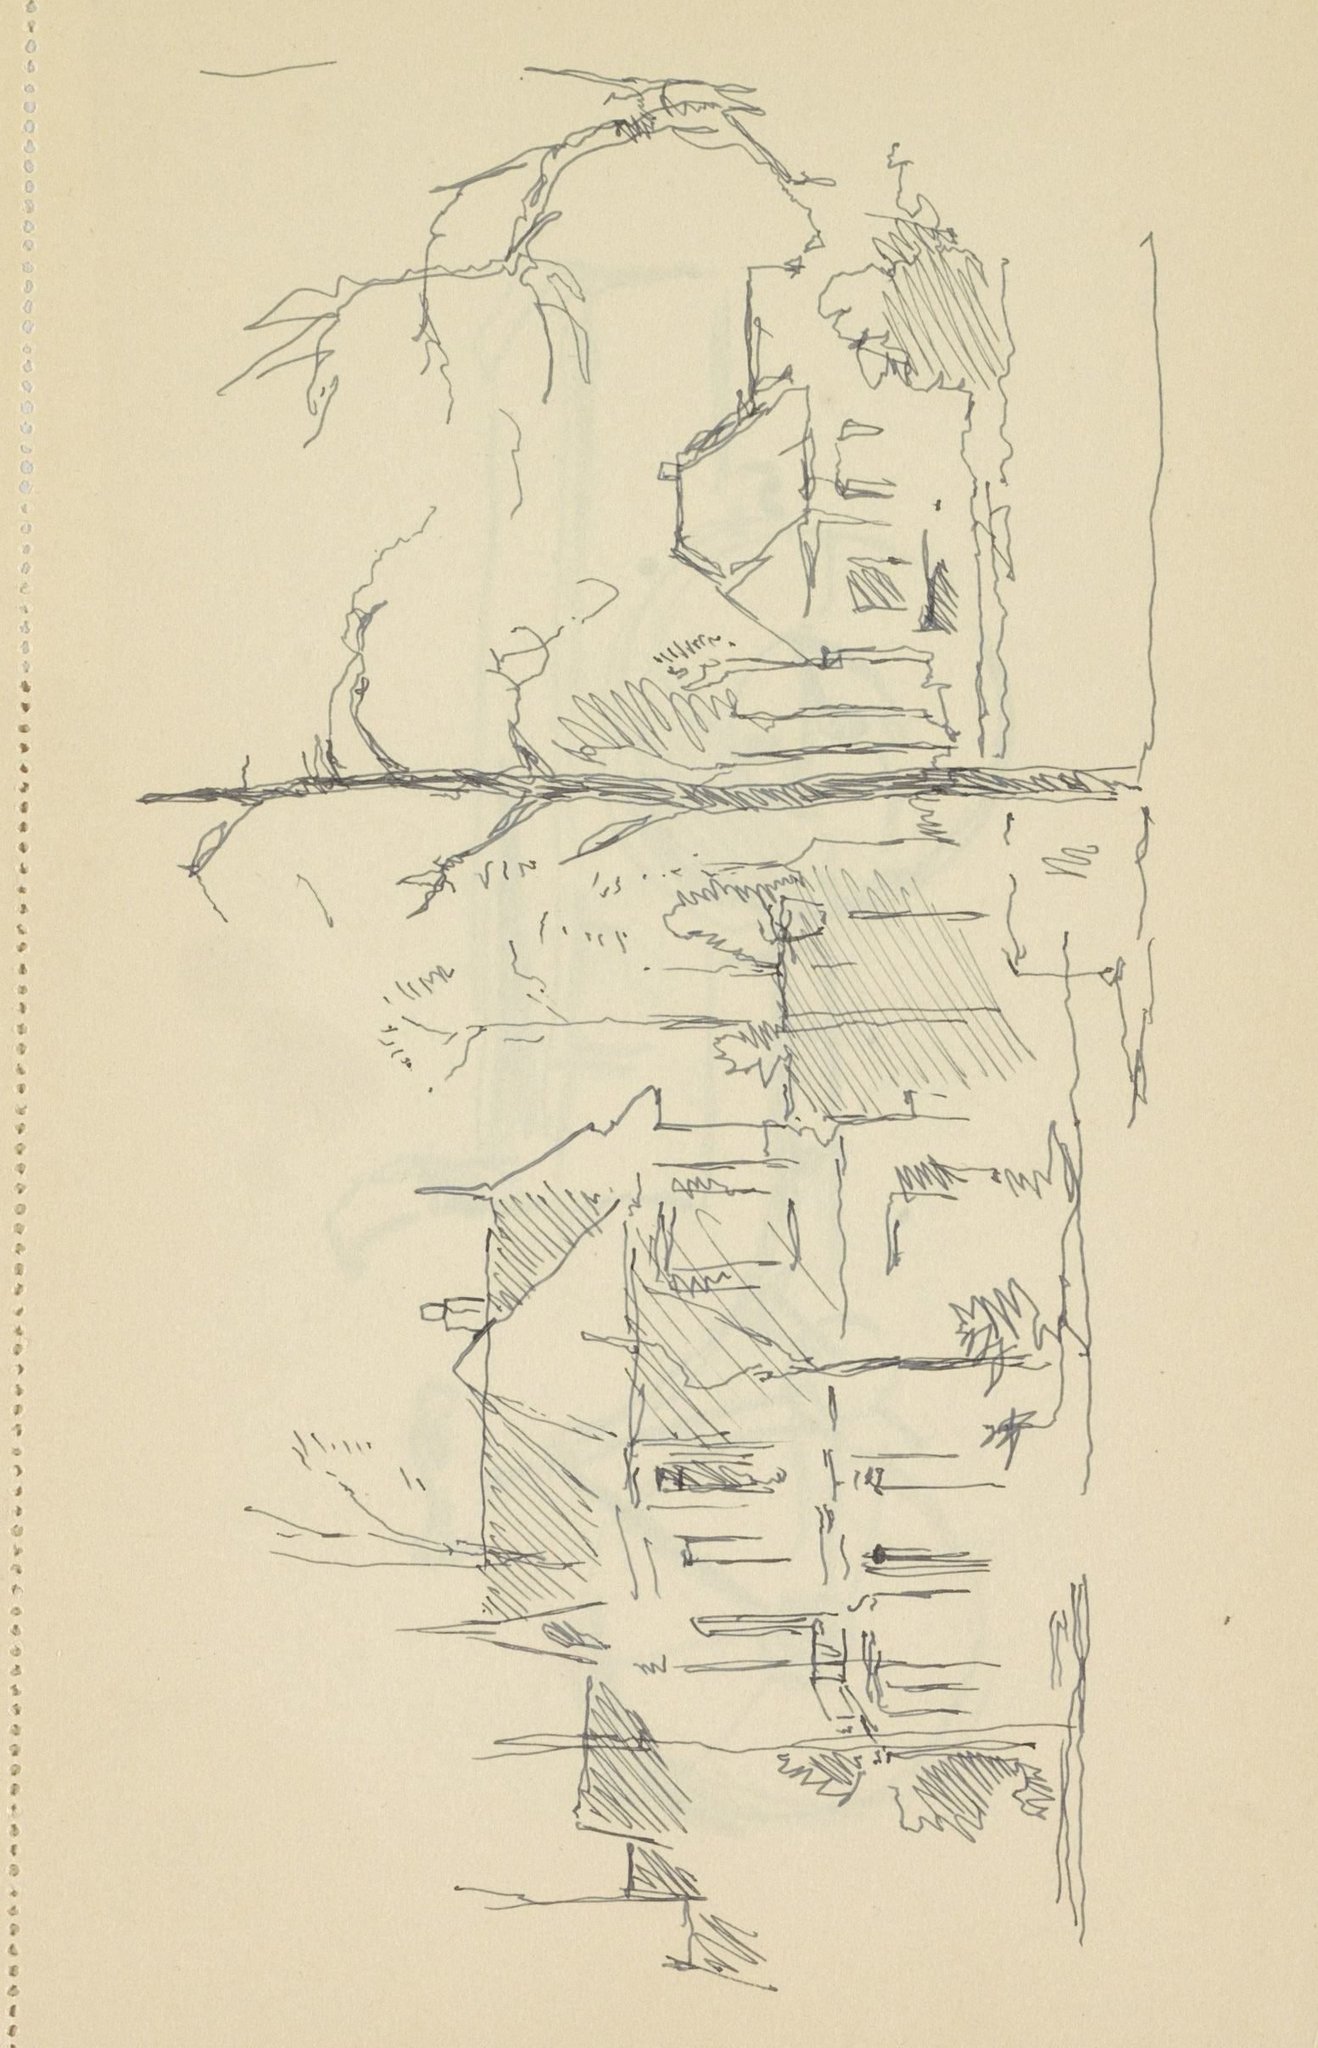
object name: sketchbook leaf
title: Straat met een rij huizen en bomen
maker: cornelis vreedenburgh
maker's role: draughtsman, print maker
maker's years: 1880-1946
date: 1890-1946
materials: ink, paper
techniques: pen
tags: street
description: Blad 19 recto uit een schetsboek met 73 bladen.